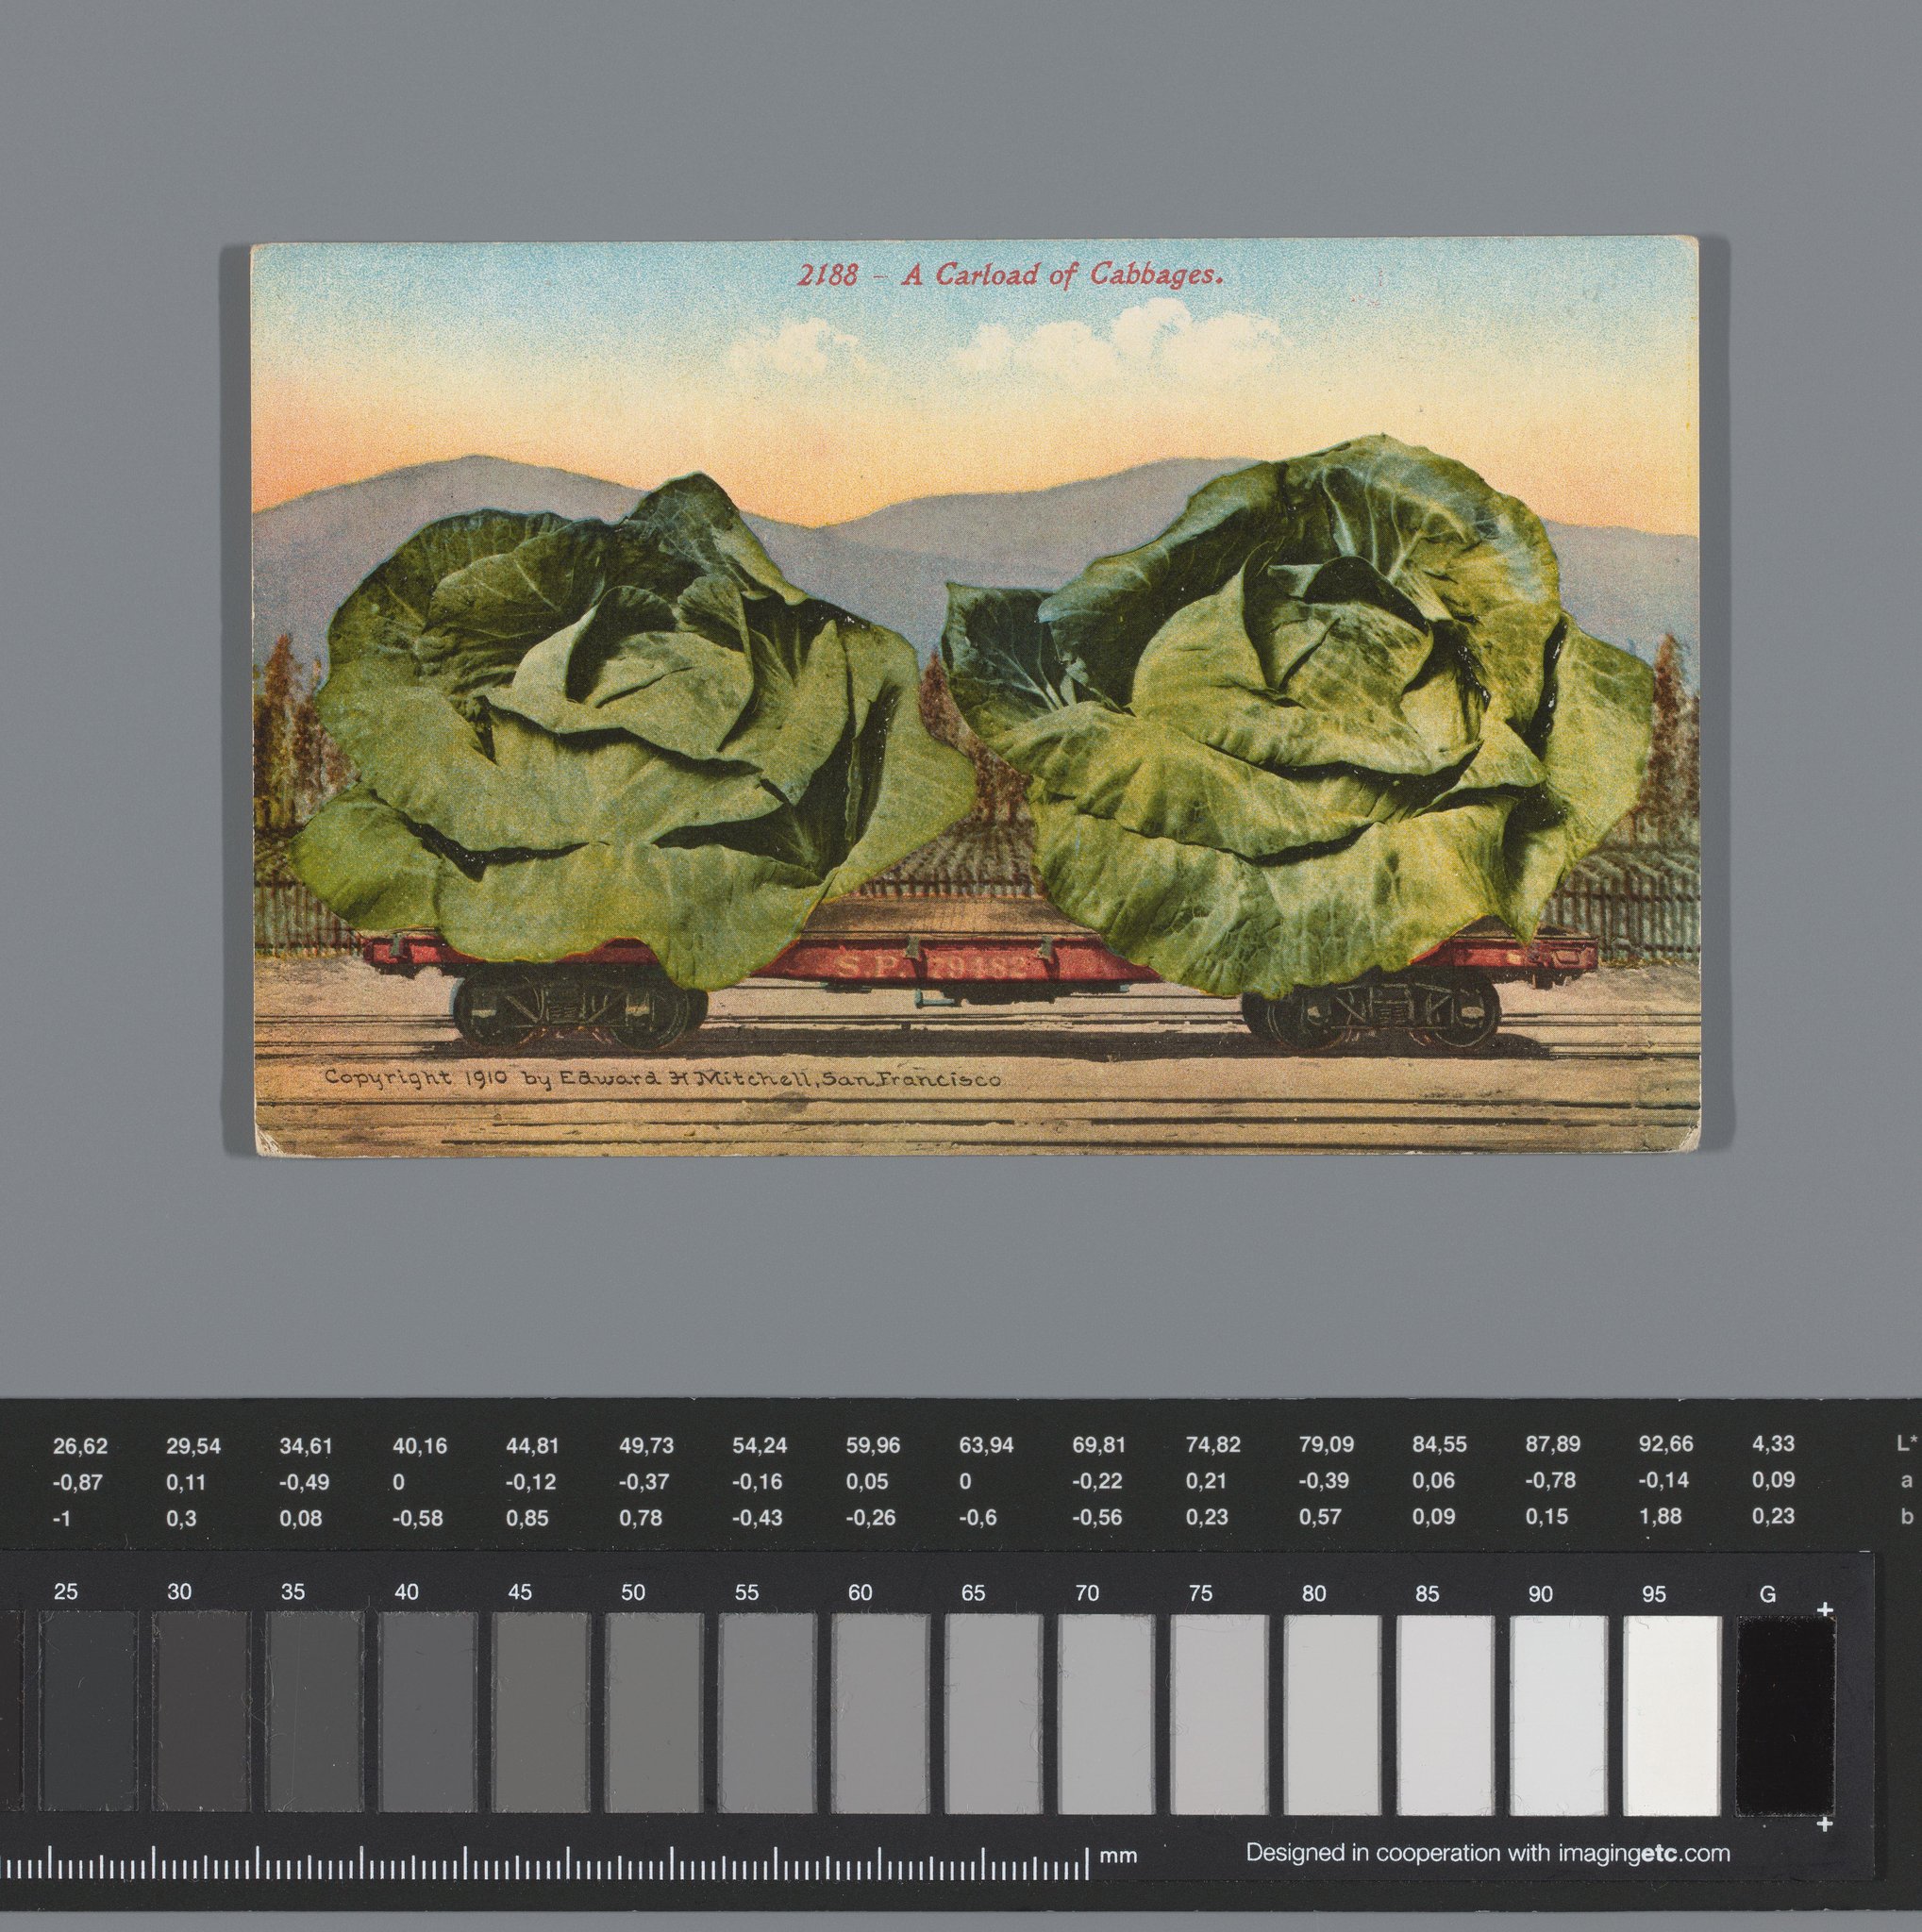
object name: ansichtkaart, prentbriefkaart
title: Treinwagon met twee reusachtige kroppen kool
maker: edward henri mitchell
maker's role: publisher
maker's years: 1867-1932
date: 1910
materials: cardboard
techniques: lithograph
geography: san francisco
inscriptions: inscription: ‘PUBLISHED BY EDWARD H. MITCHELL SAN FRANCISCO CAL.’, inscription: ‘2188 – A CARLOAD OF CABBAGES. / Copyright 1910 by Edward H. Mitchell, San Francisco’